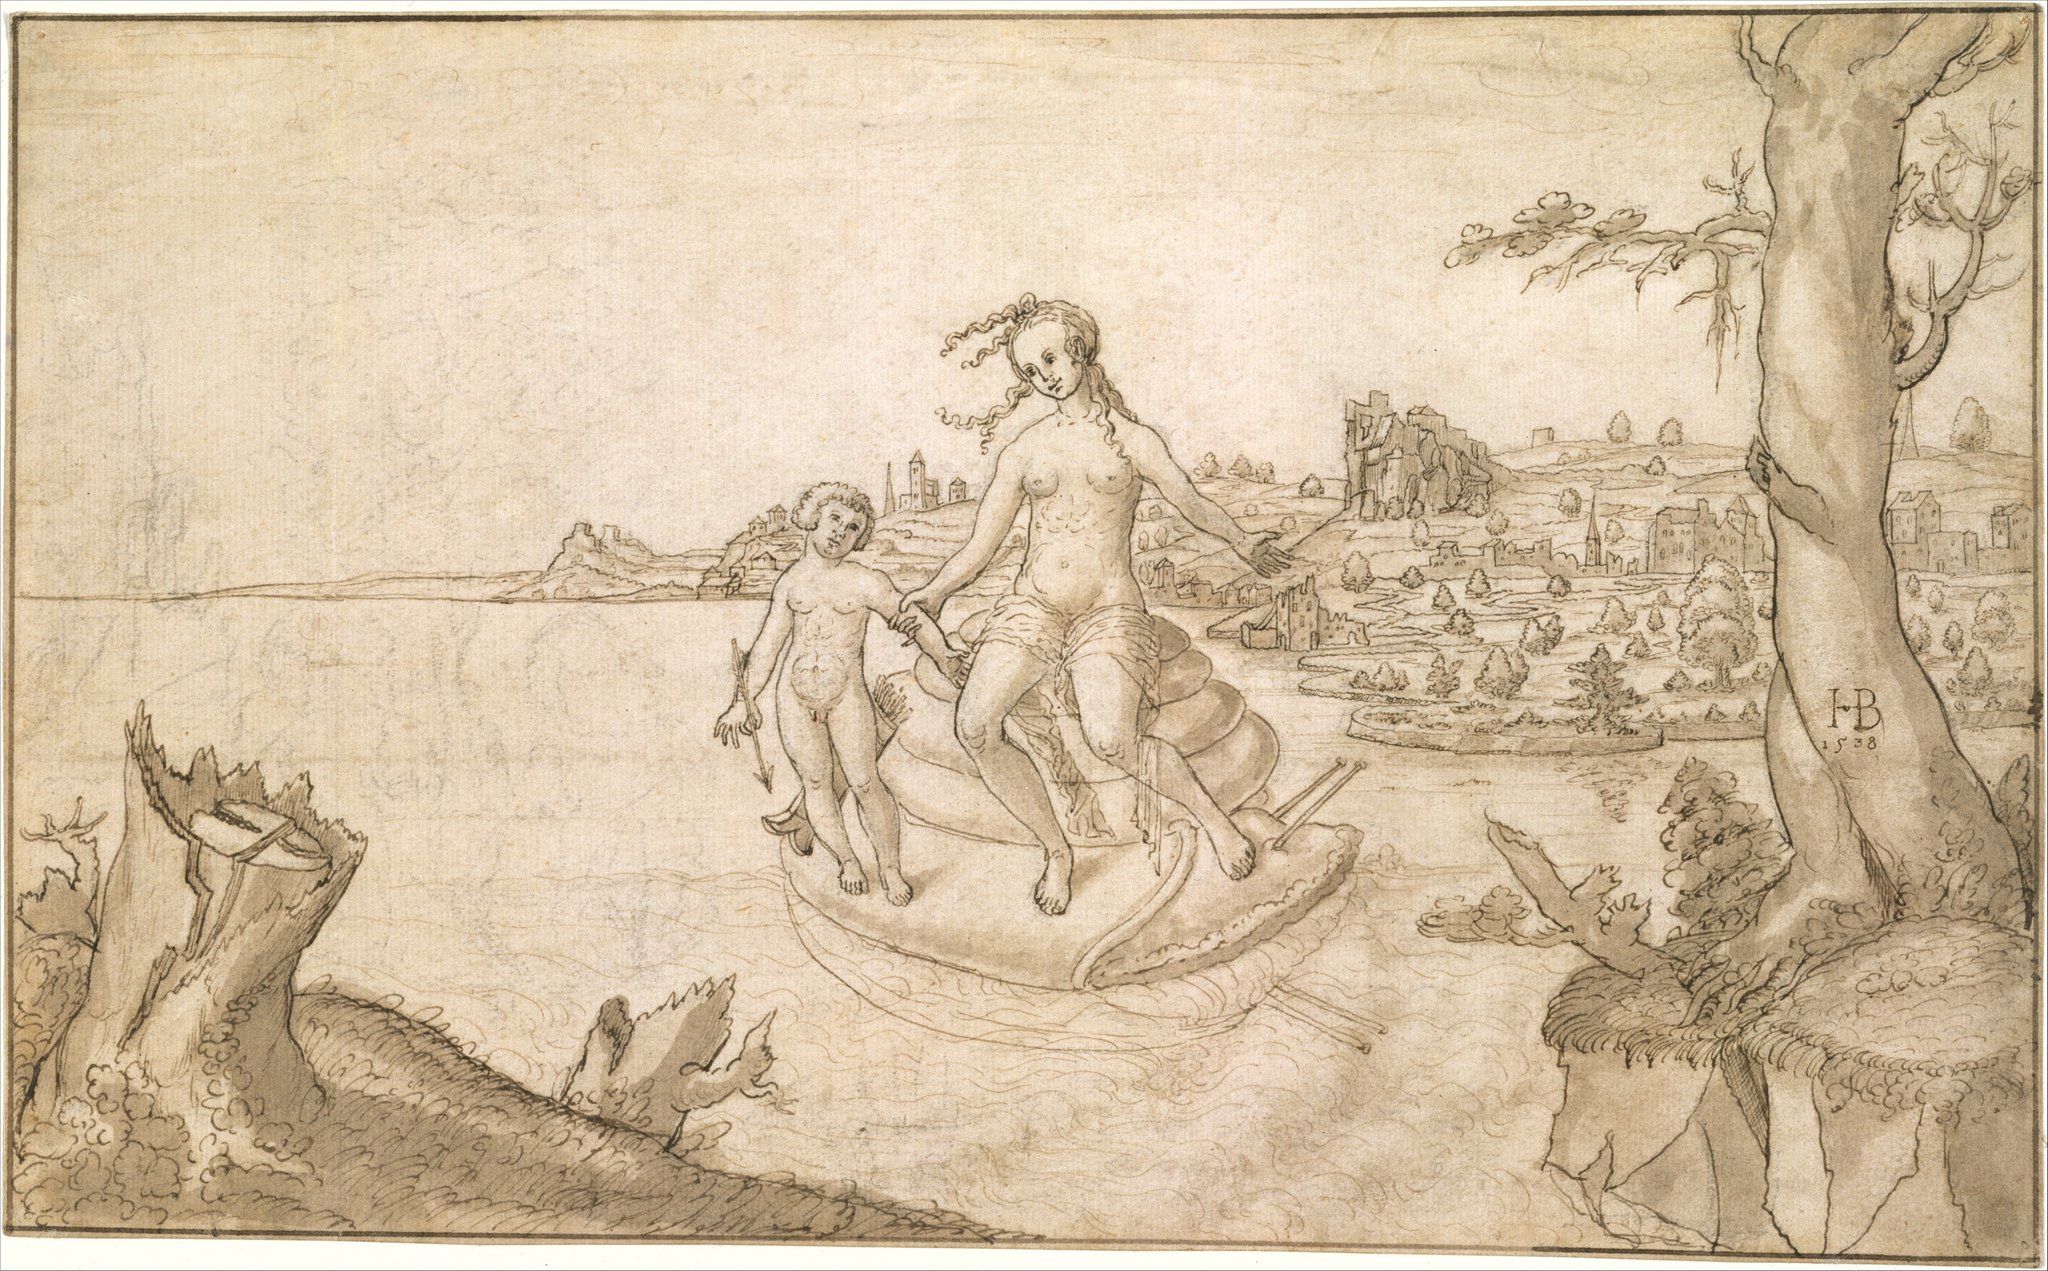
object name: drawing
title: Venus and Cupid on a Snail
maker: hans brosamer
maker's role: artist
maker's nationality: german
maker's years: 1536-1552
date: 1538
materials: chalk, charcoal, ink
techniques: drawing, pen, wash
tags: cupid,venus,snails